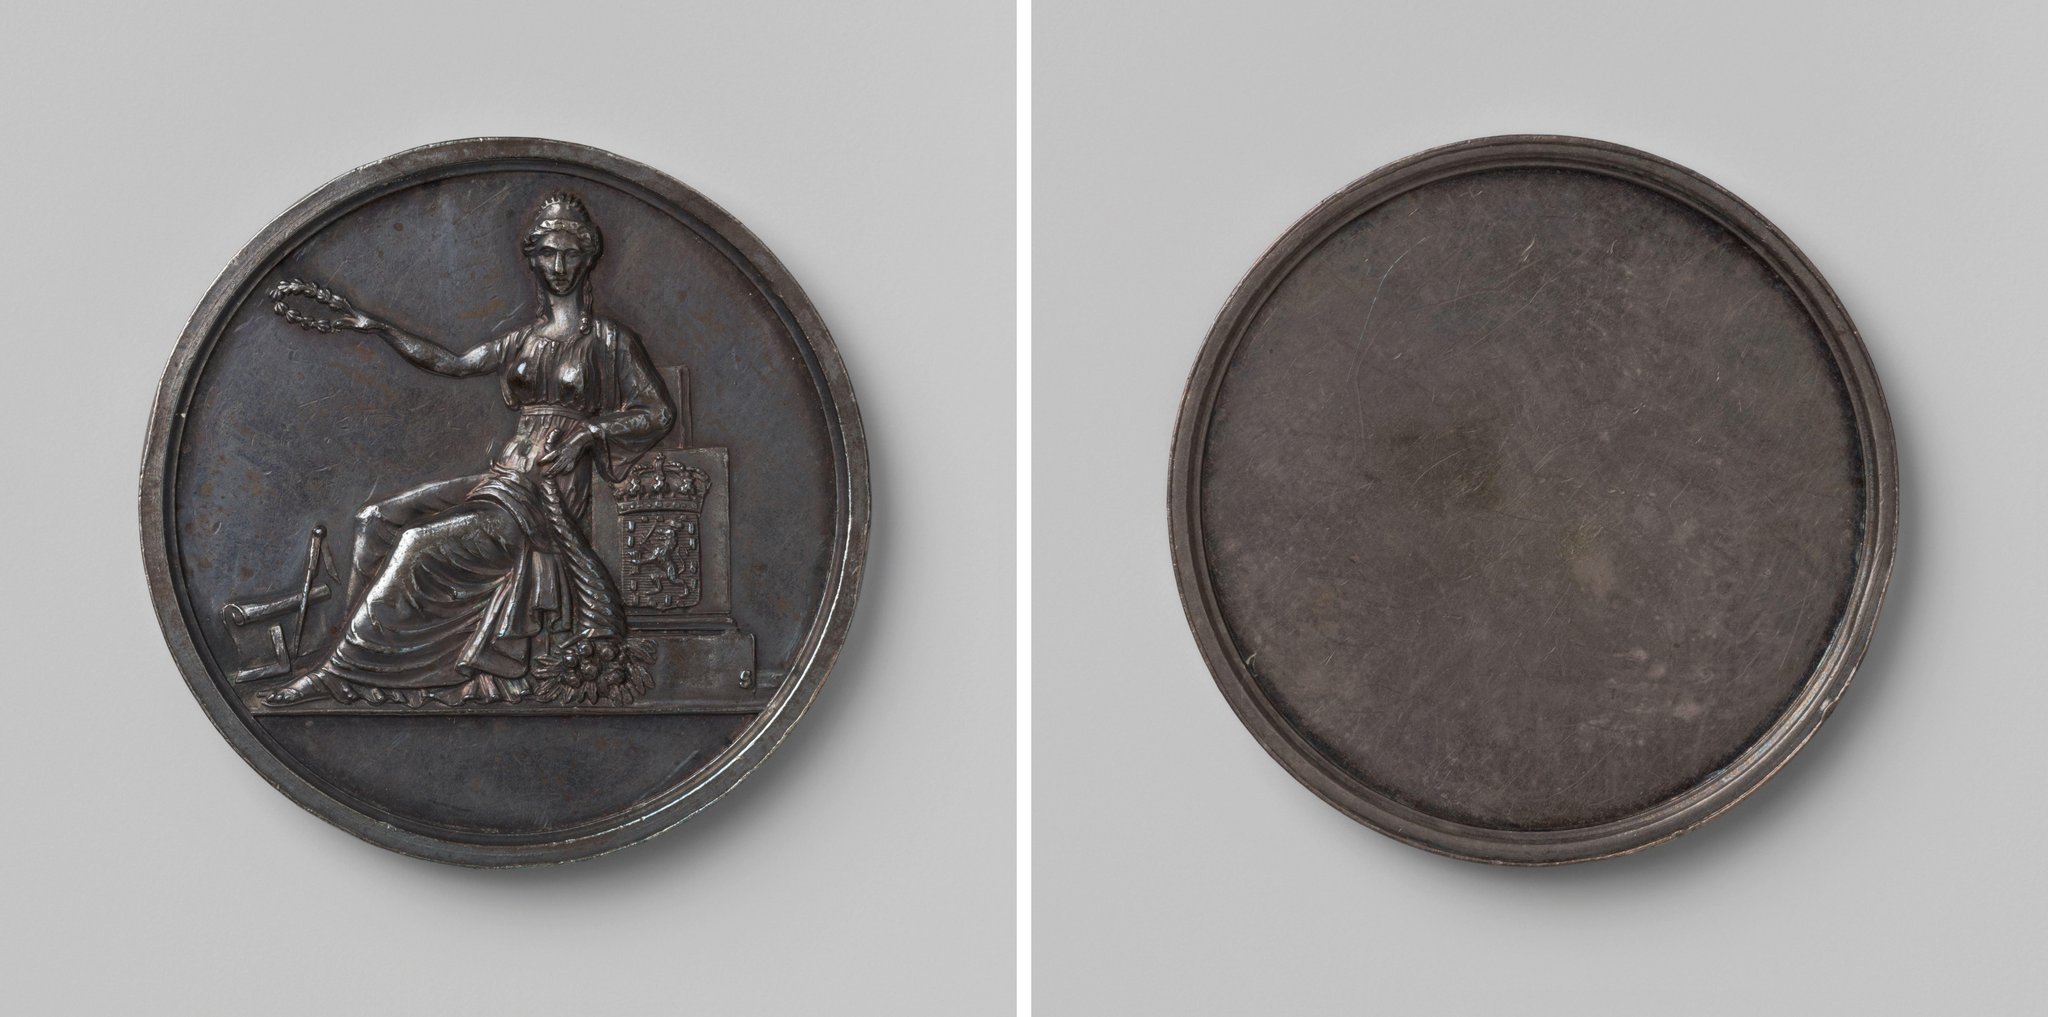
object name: medal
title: Akademie van Beeldende Kunsten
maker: jean henri simon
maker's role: medailleur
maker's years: 1752-1834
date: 1817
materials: silver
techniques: striking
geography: brussels